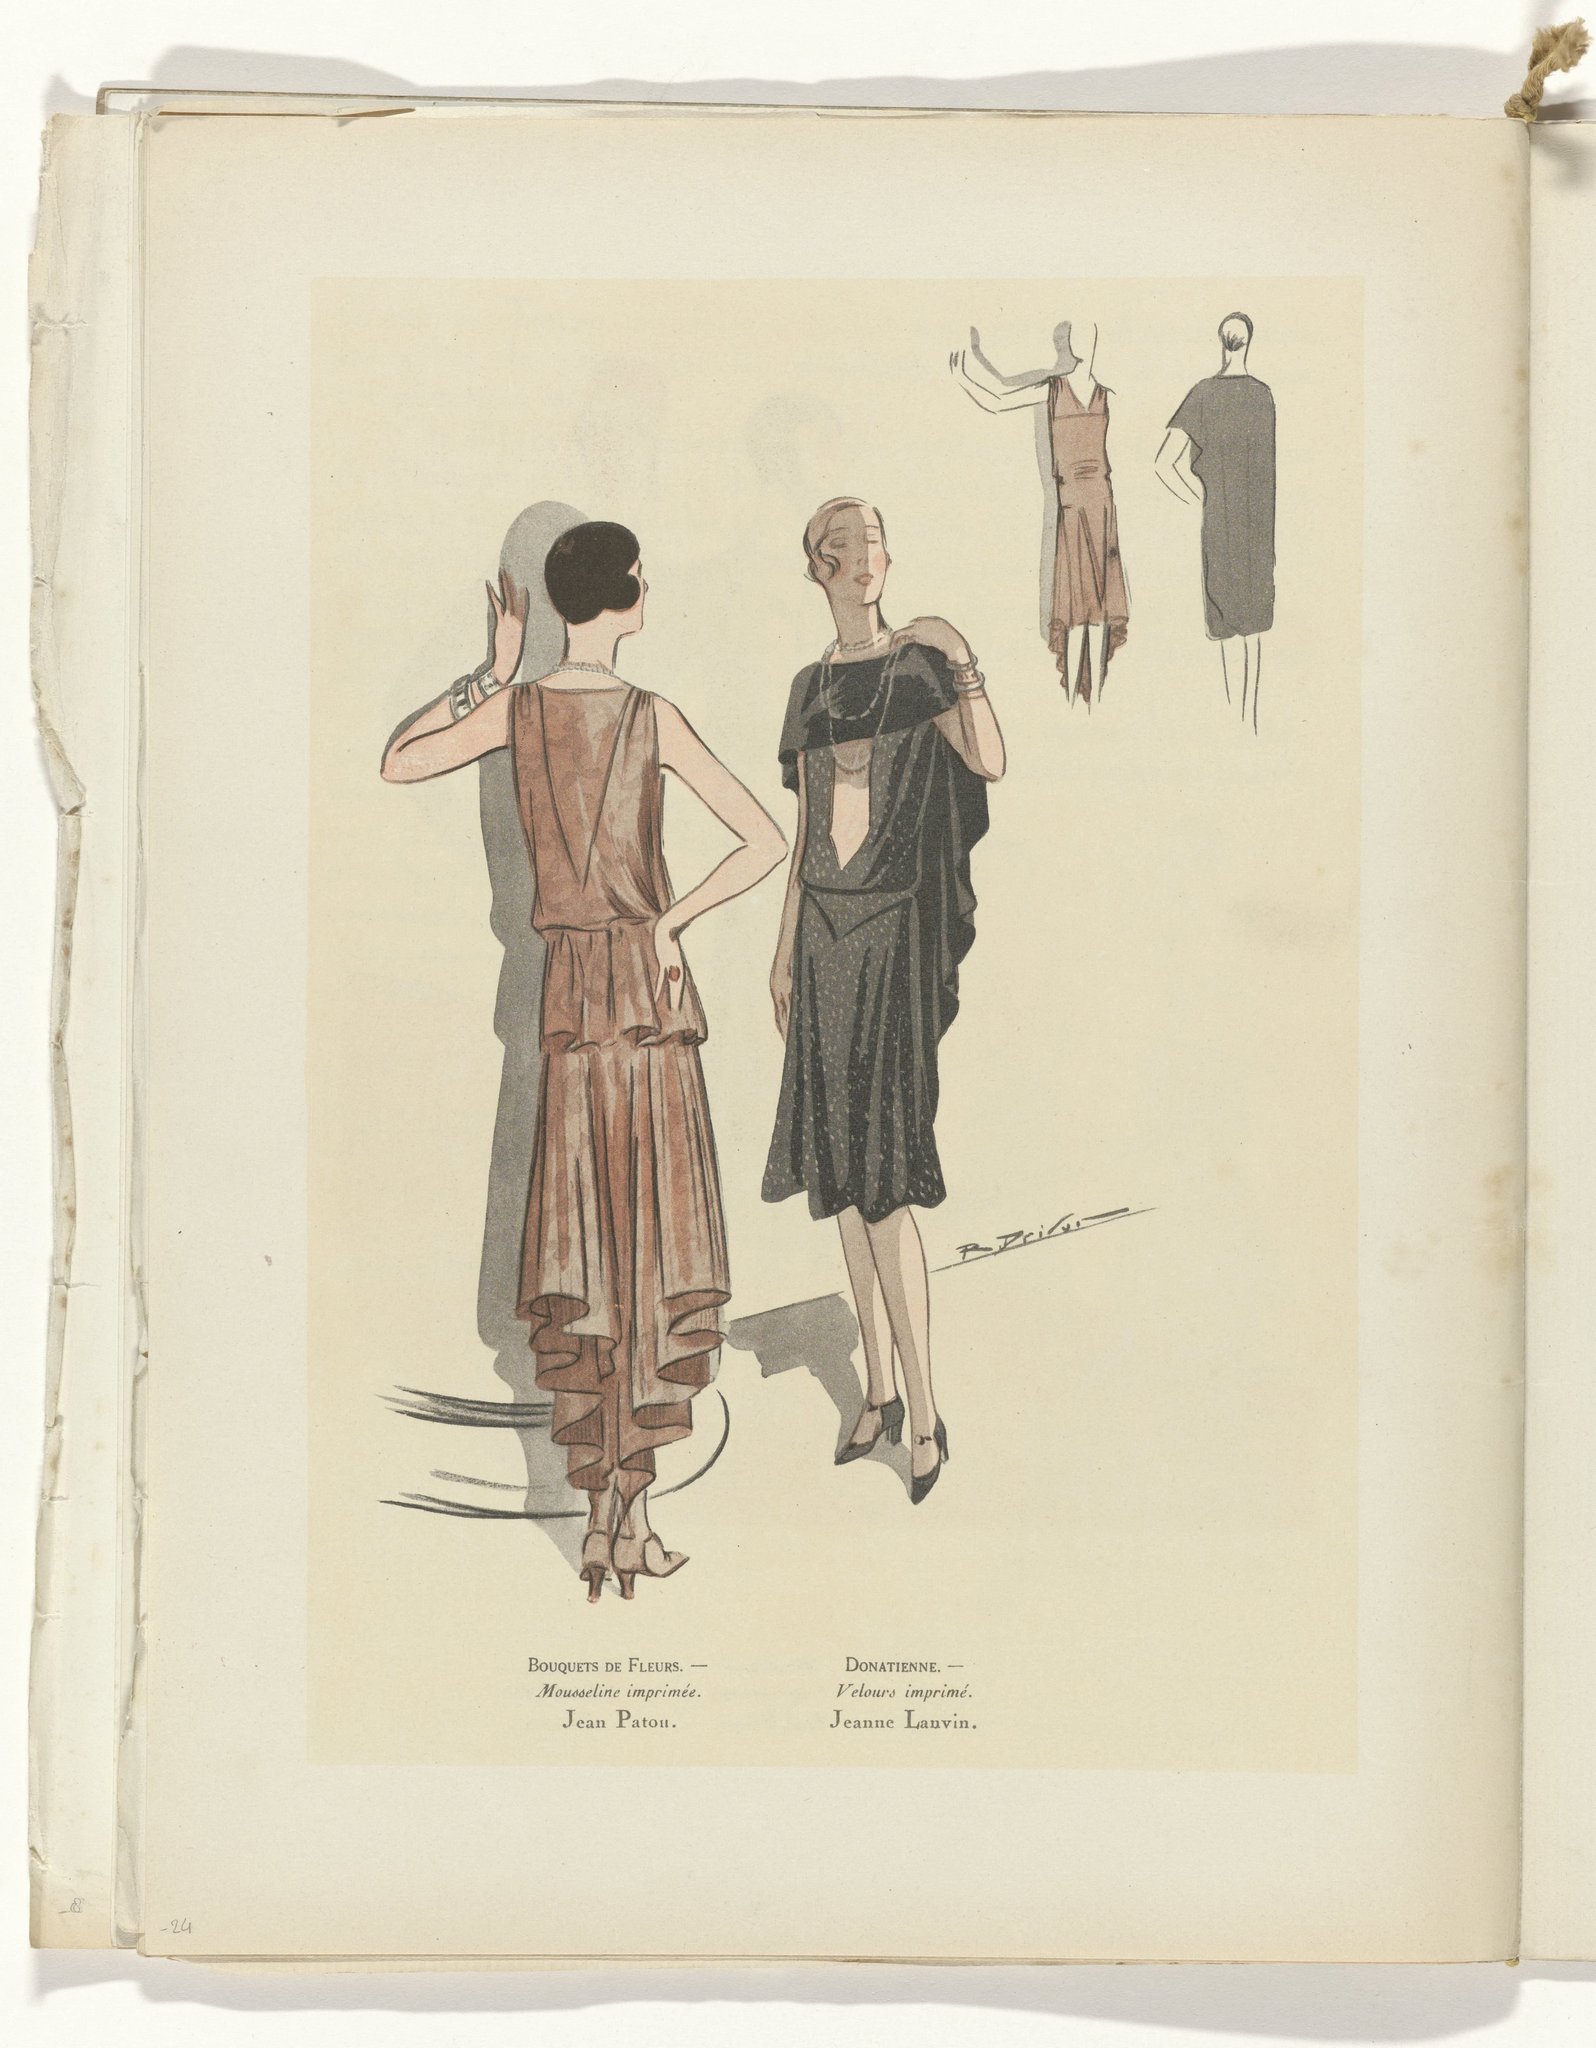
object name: fashion print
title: Art - Goût - Beauté, Feuillets de l' élégance féminine, Mars 1929, No. 103, 9e Année, p. 24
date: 1929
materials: paper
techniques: printing, photography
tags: dress, gown: evening dress (+ women's clothes), fashion plates, bracelet, wristlet (+ women's clothes), necklace (+ women's clothes)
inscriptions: caption: ‘BOUQUETS DE FLEURS. -Mousseline imrpimée. Jean Patou. / DONATIENNE. - Velours imprimé. Jeanne Lanvin.’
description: Twee vrouwen, gekleed in japonnen van Jean Patou (japon van bedrukt mousseline) en Jeanne Lanvin (japon van bedrukt fluweel, met stola. Pagina uit het modetijdschrift Art-Goût-Beauté (1920-1933).